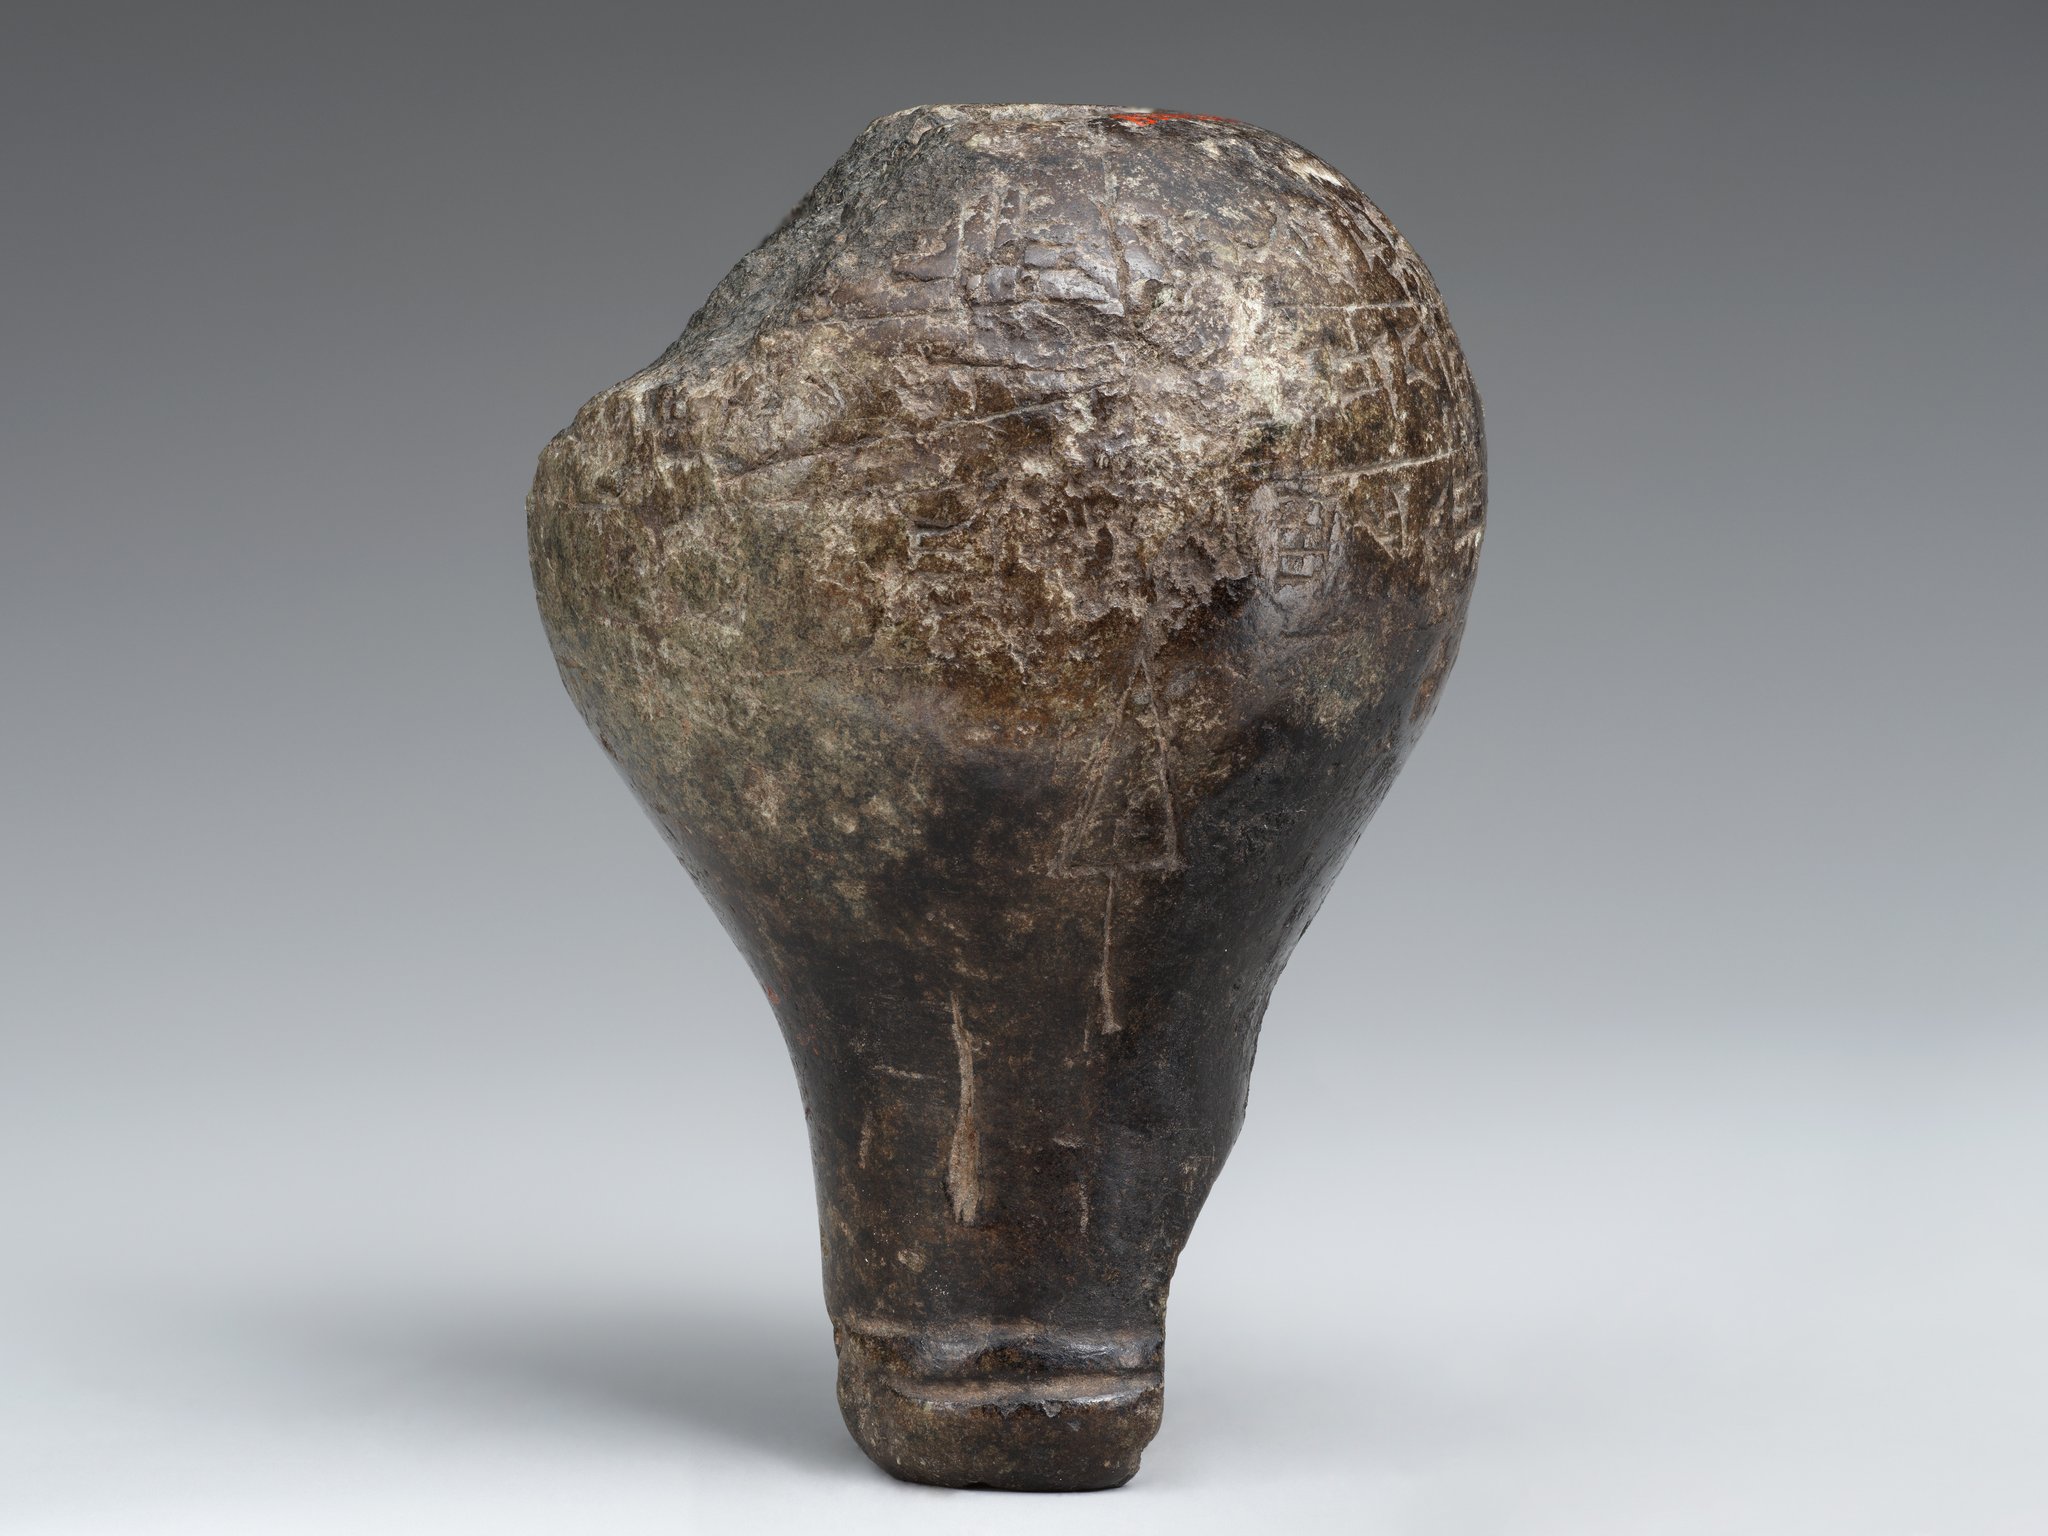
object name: mace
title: Mace head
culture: kassite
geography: mesopotamia